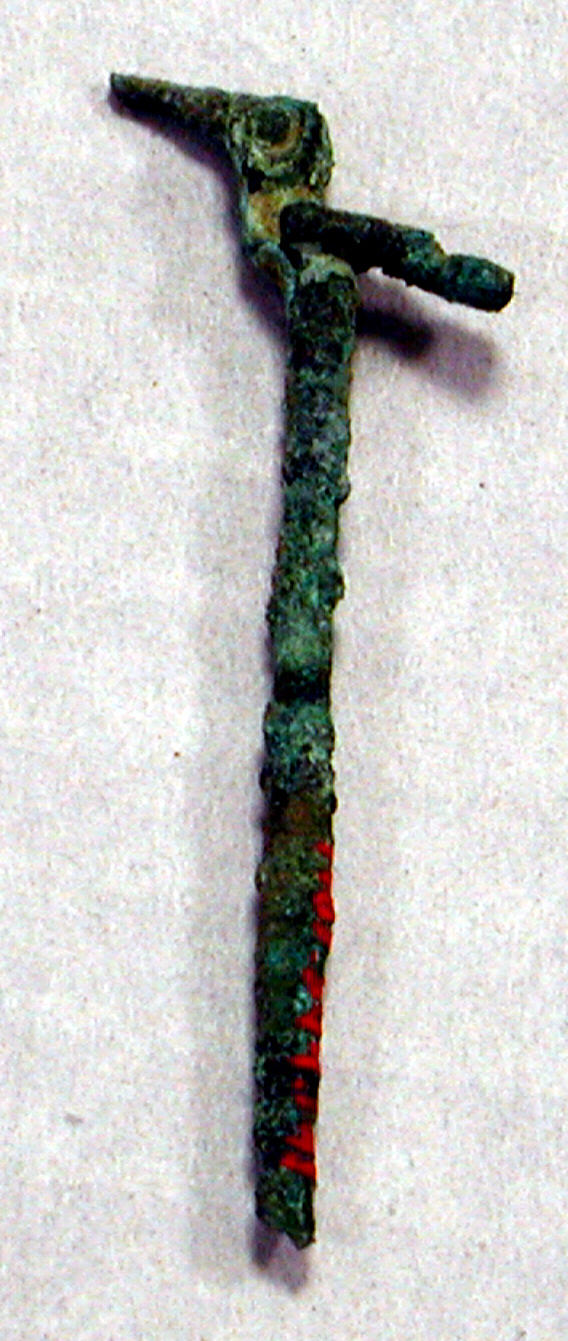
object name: lime spoon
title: Copper Lime Spoon with Bird Top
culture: inca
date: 1401-1600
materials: copper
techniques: casting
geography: peru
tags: birds